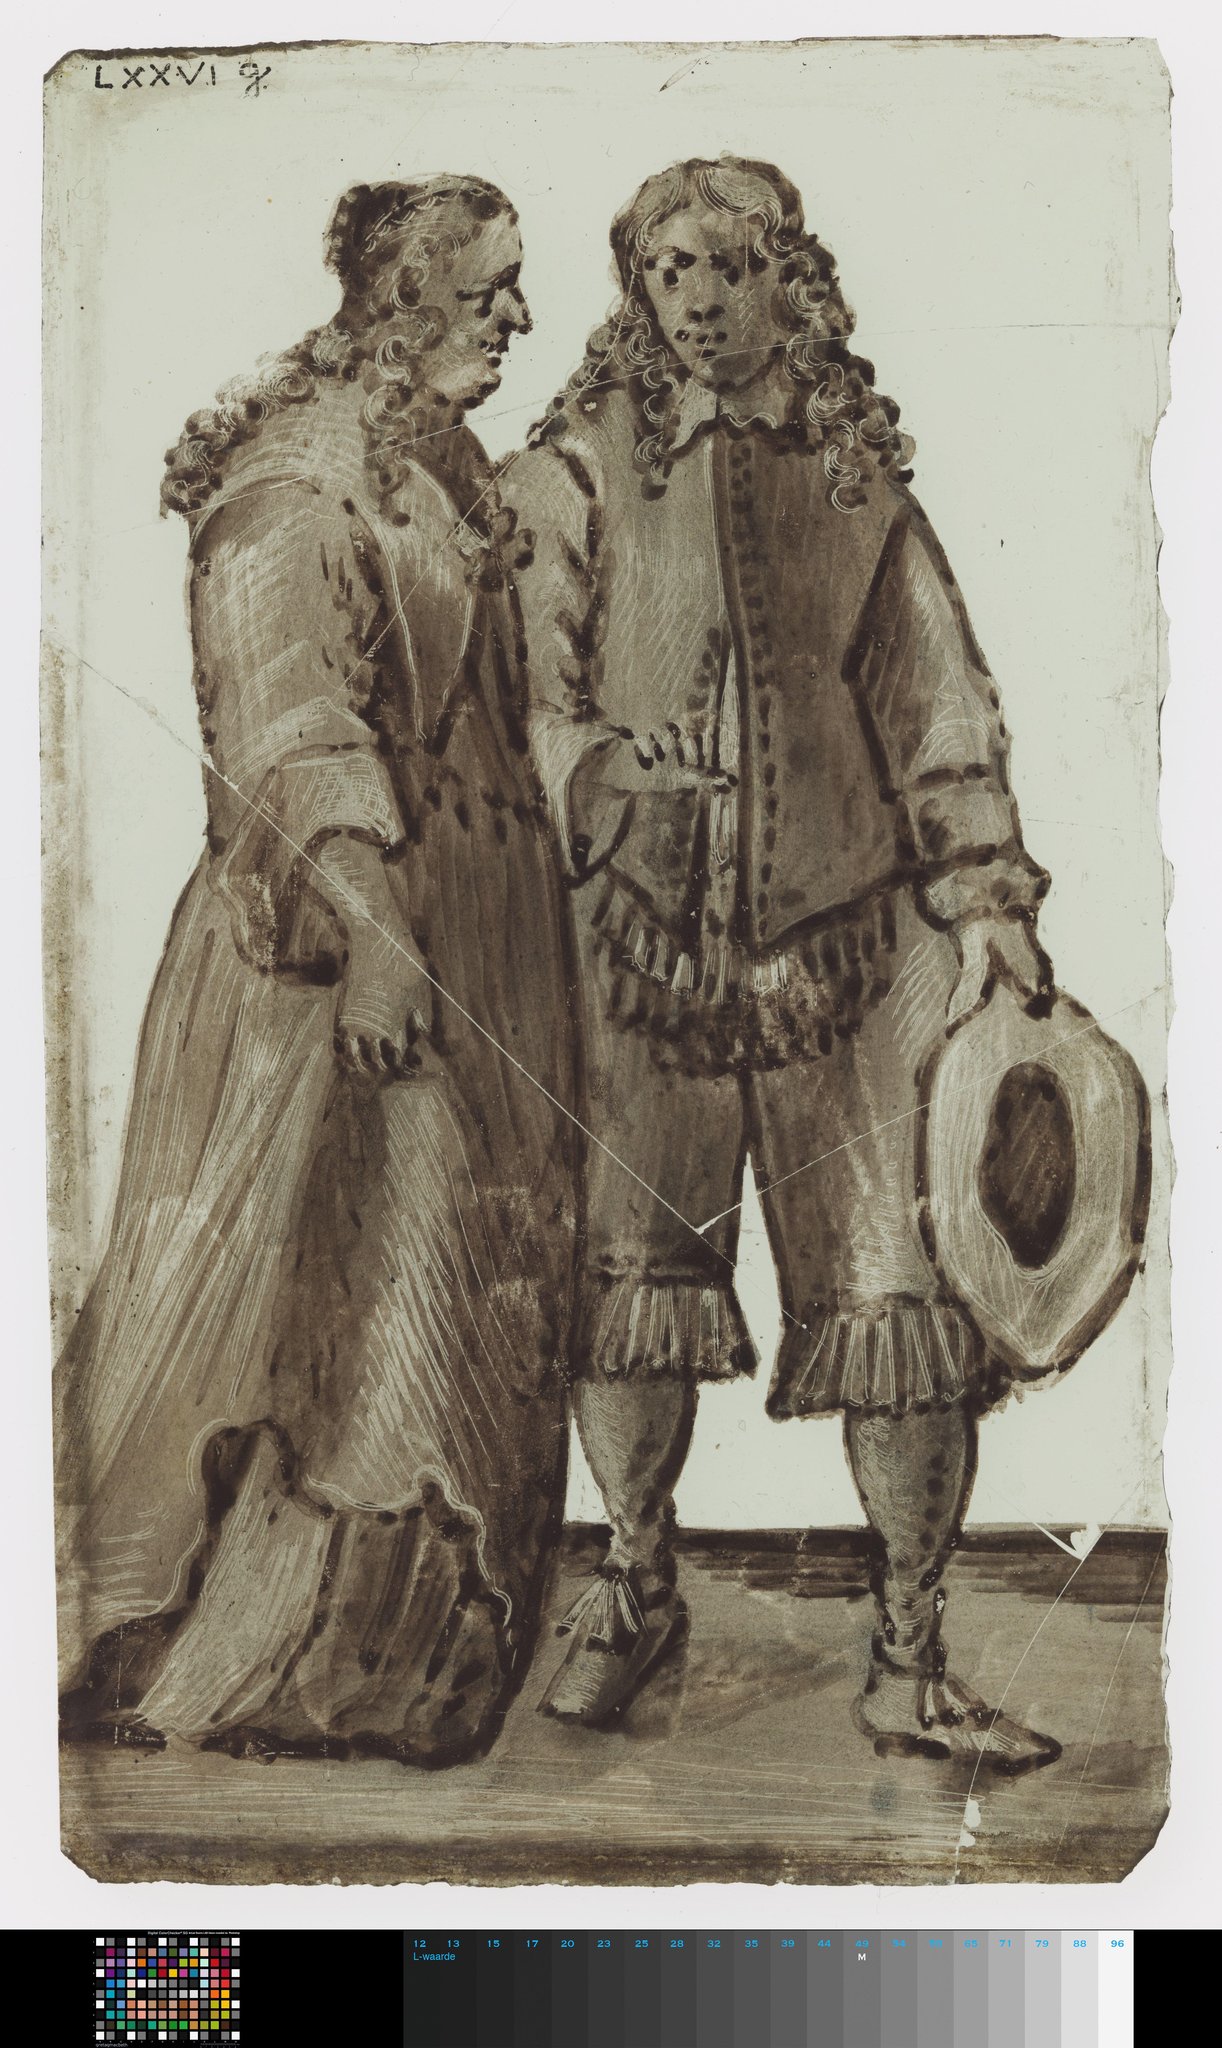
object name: light window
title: Ruit met man en vrouw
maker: Anonymous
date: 1650-1675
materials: glass, lead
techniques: enamel painting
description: Gebrandschilderde ruit, in grisaille, met de afbeelding van een man en een vrouw. De man houdt de hand van de vrouw vast. In zijn andere hand heeft hij een hoed.